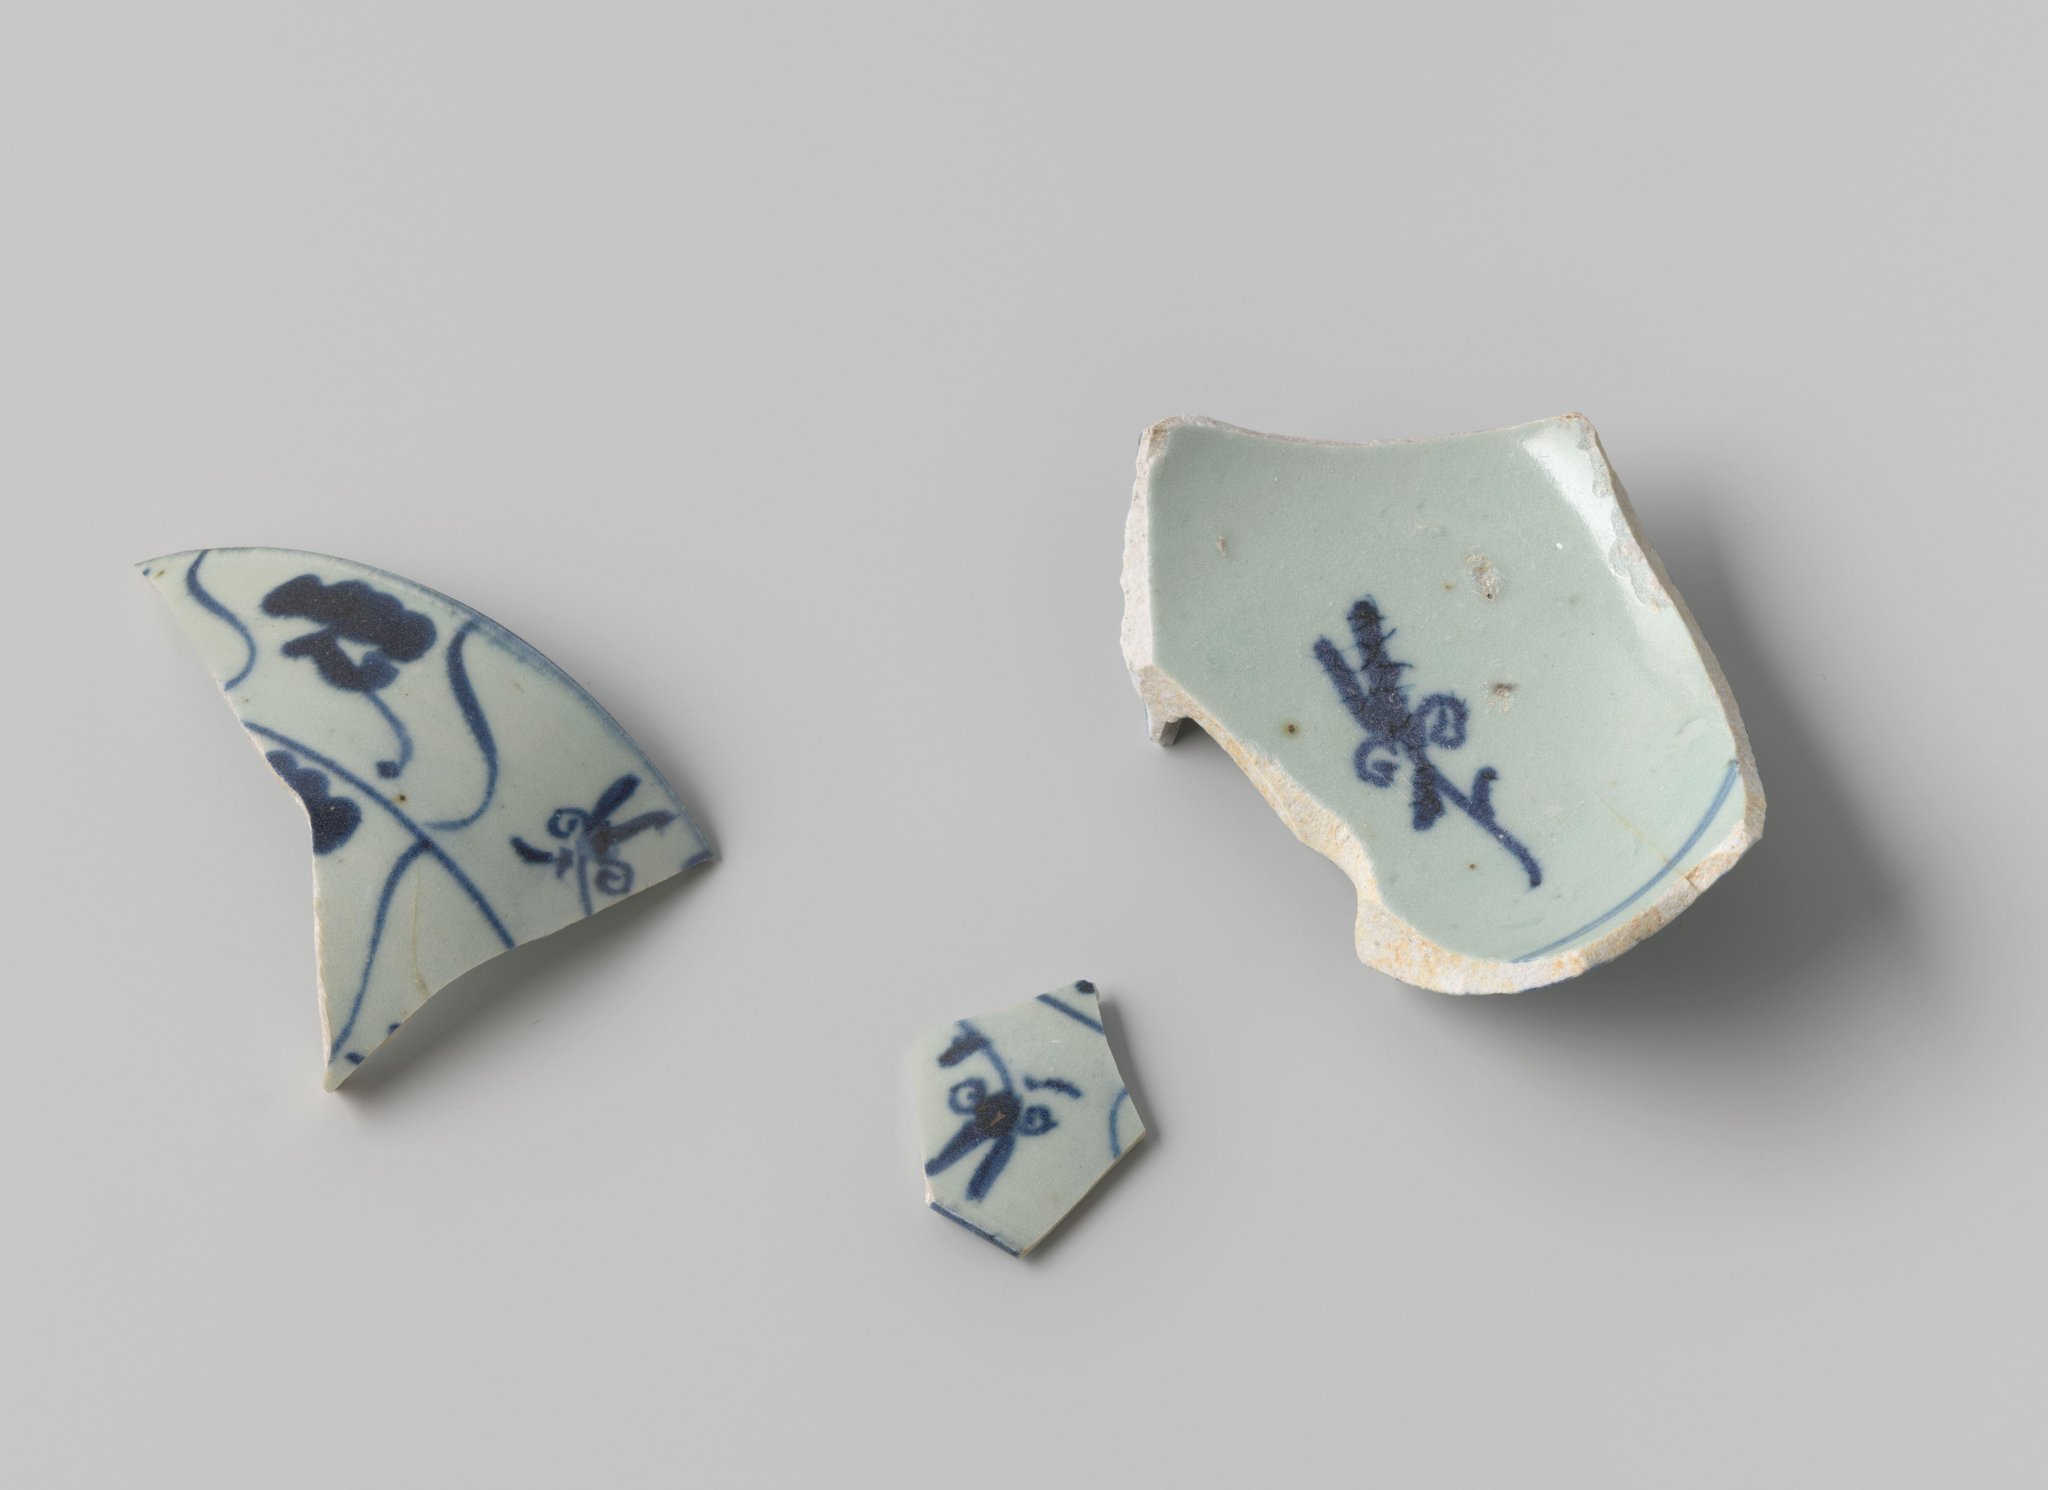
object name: bowl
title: Scherven van een kom uit V.O.C.-schip de 'Witte Leeuw'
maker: Anonymous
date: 1613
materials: porcelain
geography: jingdezhen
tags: verenigde oostindische compagnie, sint-helena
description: A bowl. In the centre a sketchily painted flower. On the glazed bottom is a mark, the top is meaningless, the bottom one could be: ru (ju), i.e. jade.